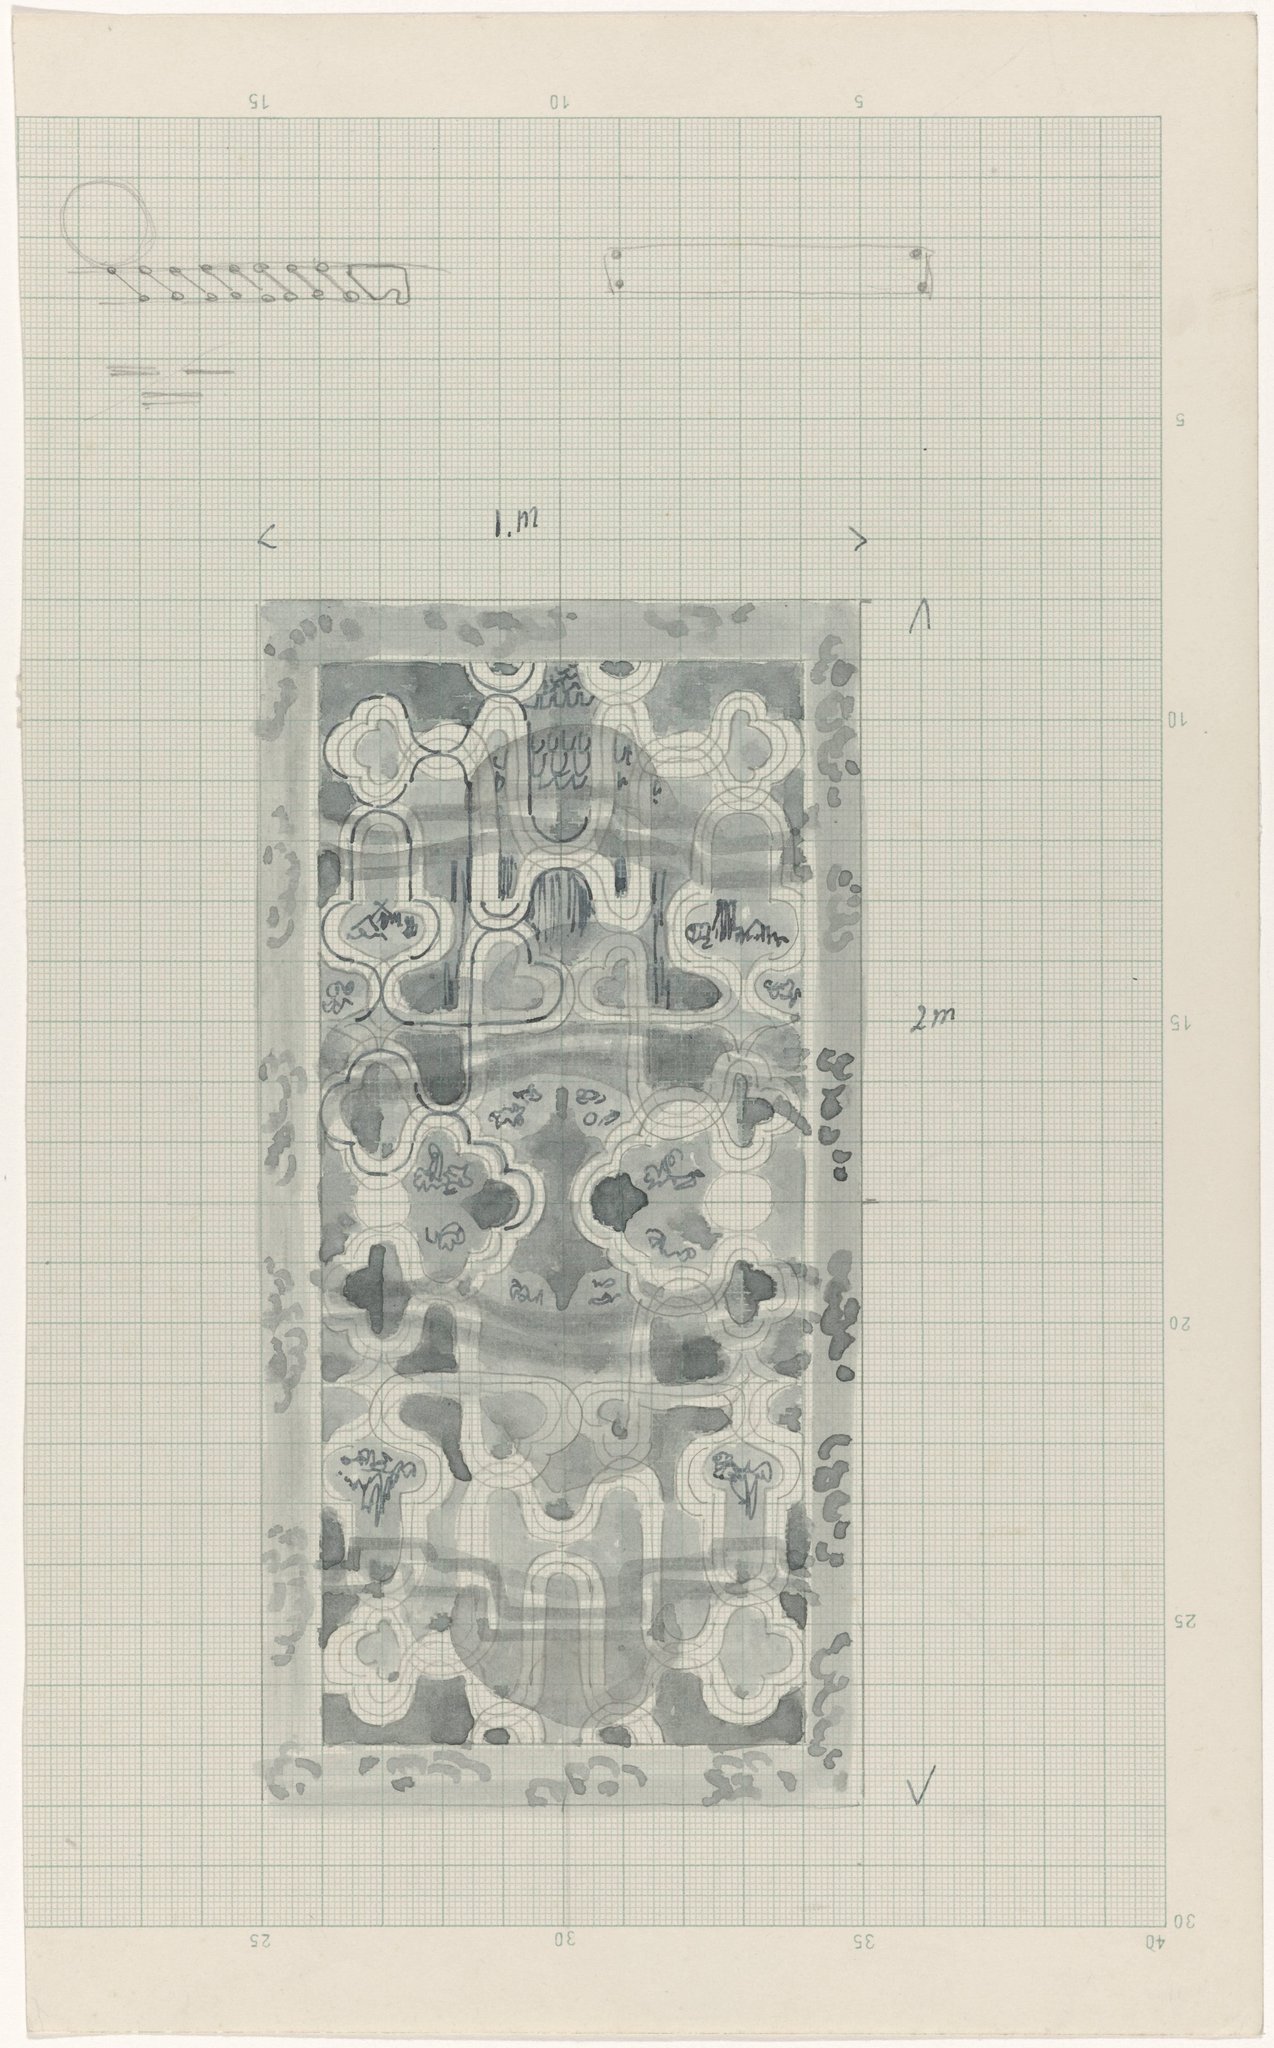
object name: design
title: Decoratief ontwerp in grijsblauw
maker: carel adolph lion cachet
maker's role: draughtsman, print maker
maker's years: 1864-1945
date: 1874-1945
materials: ink, pencil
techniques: brush, pen